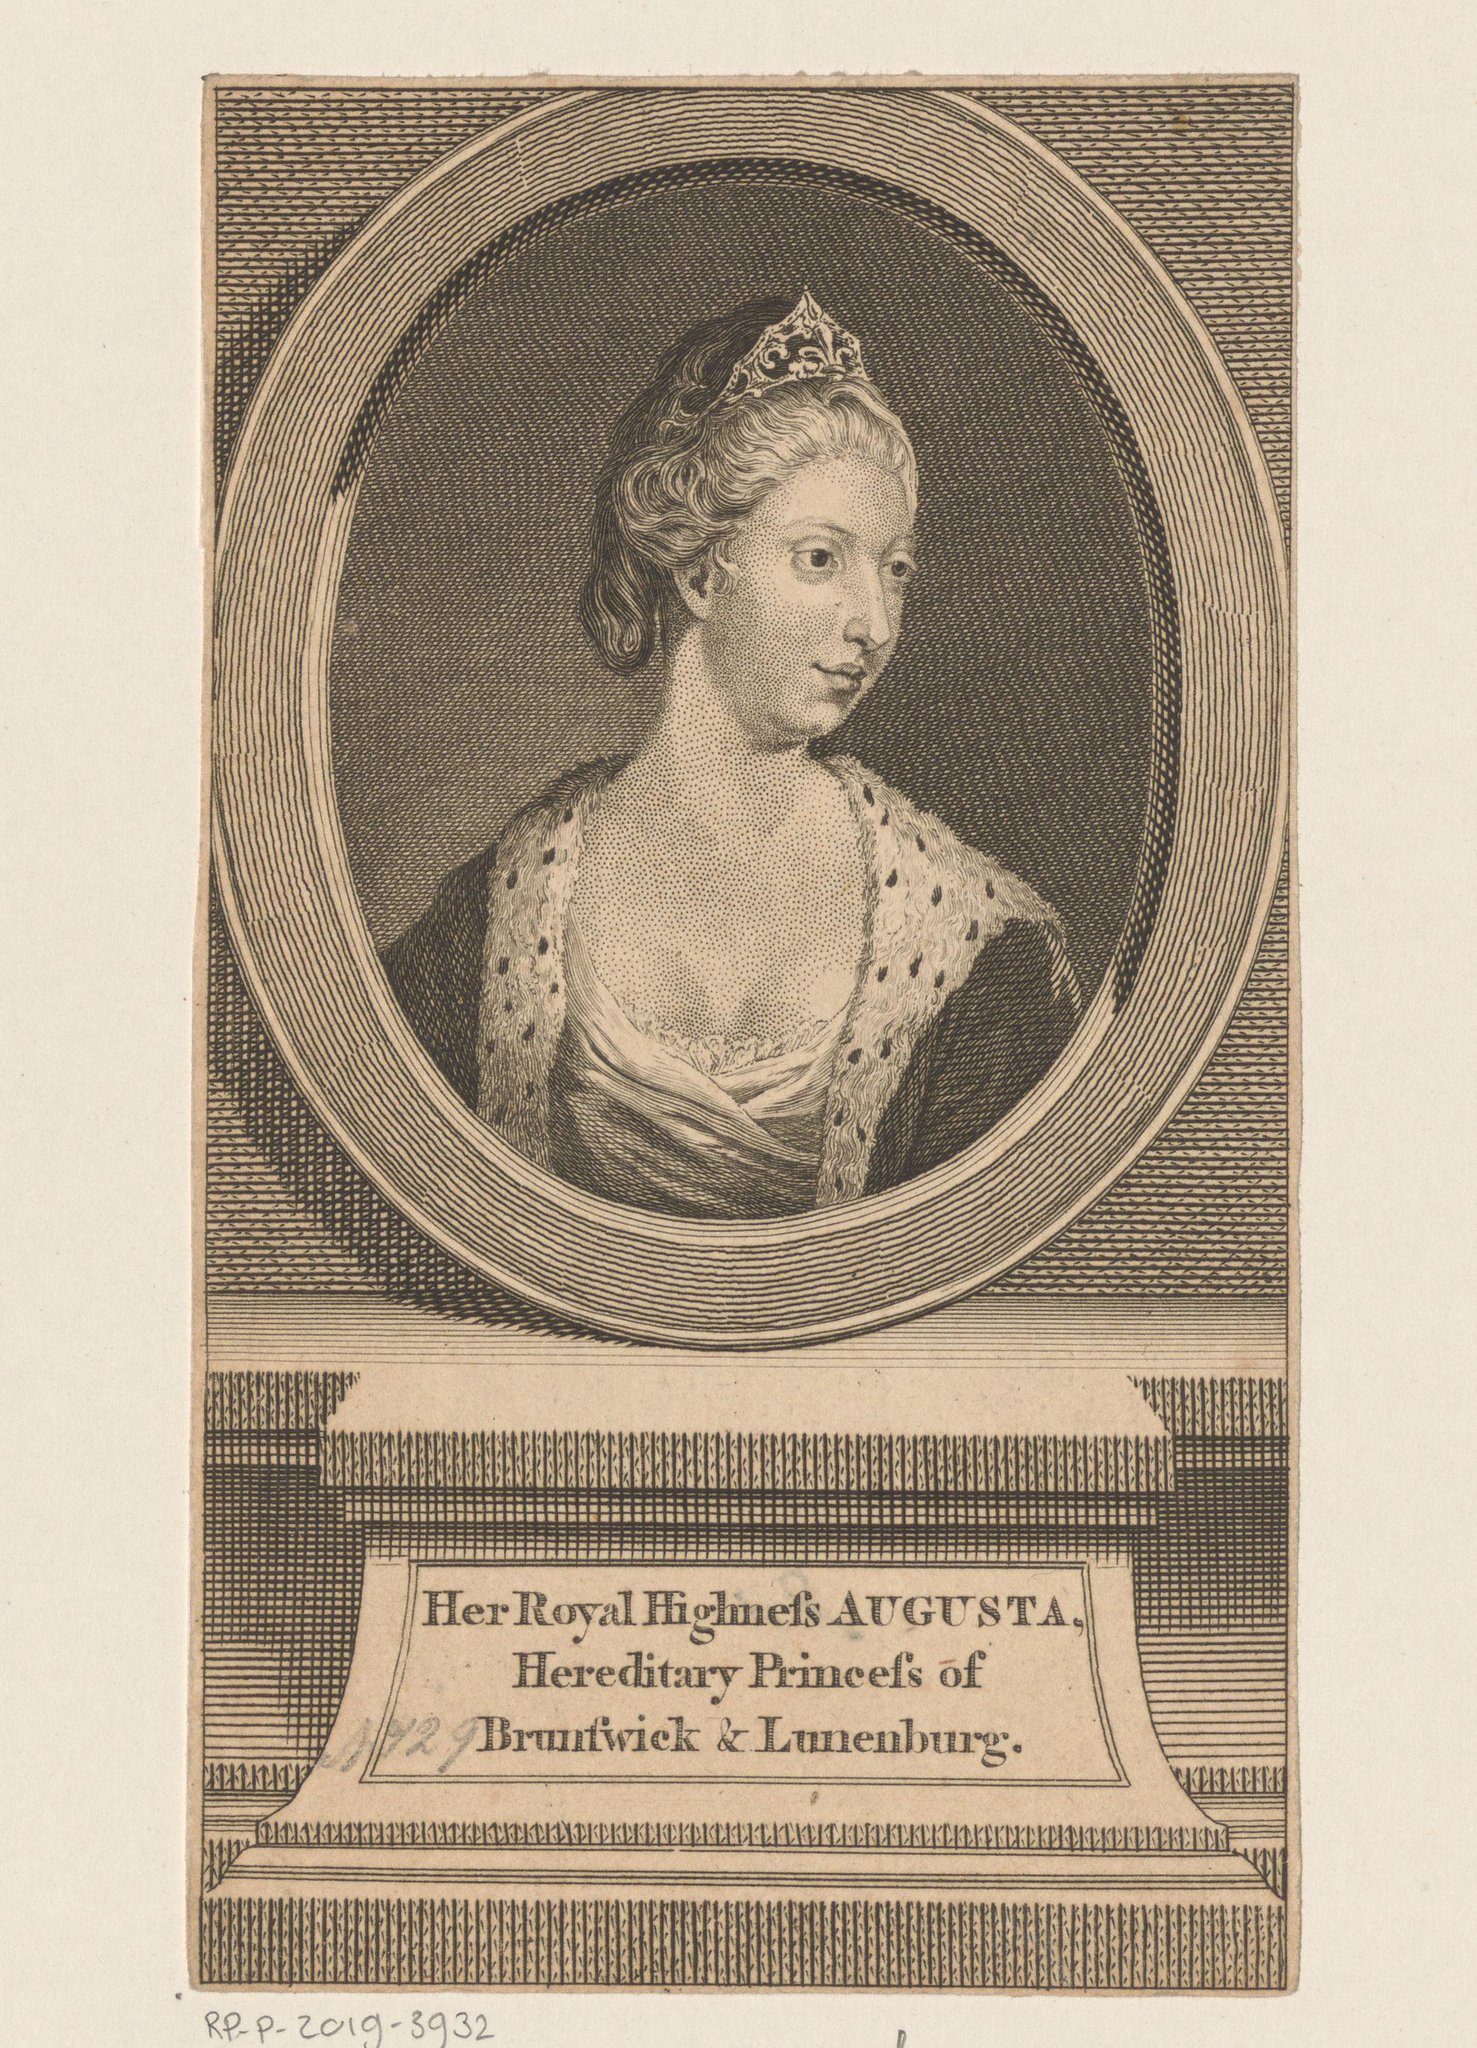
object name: print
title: Portret van Augusta Frederika, prinses van Wales en hertogin van Brunswick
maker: Anonymous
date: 1750-1799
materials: paper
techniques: engraving, etching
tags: historical persons - bb - woman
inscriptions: inscription: ‘80 / 98 [doorgestreept]’